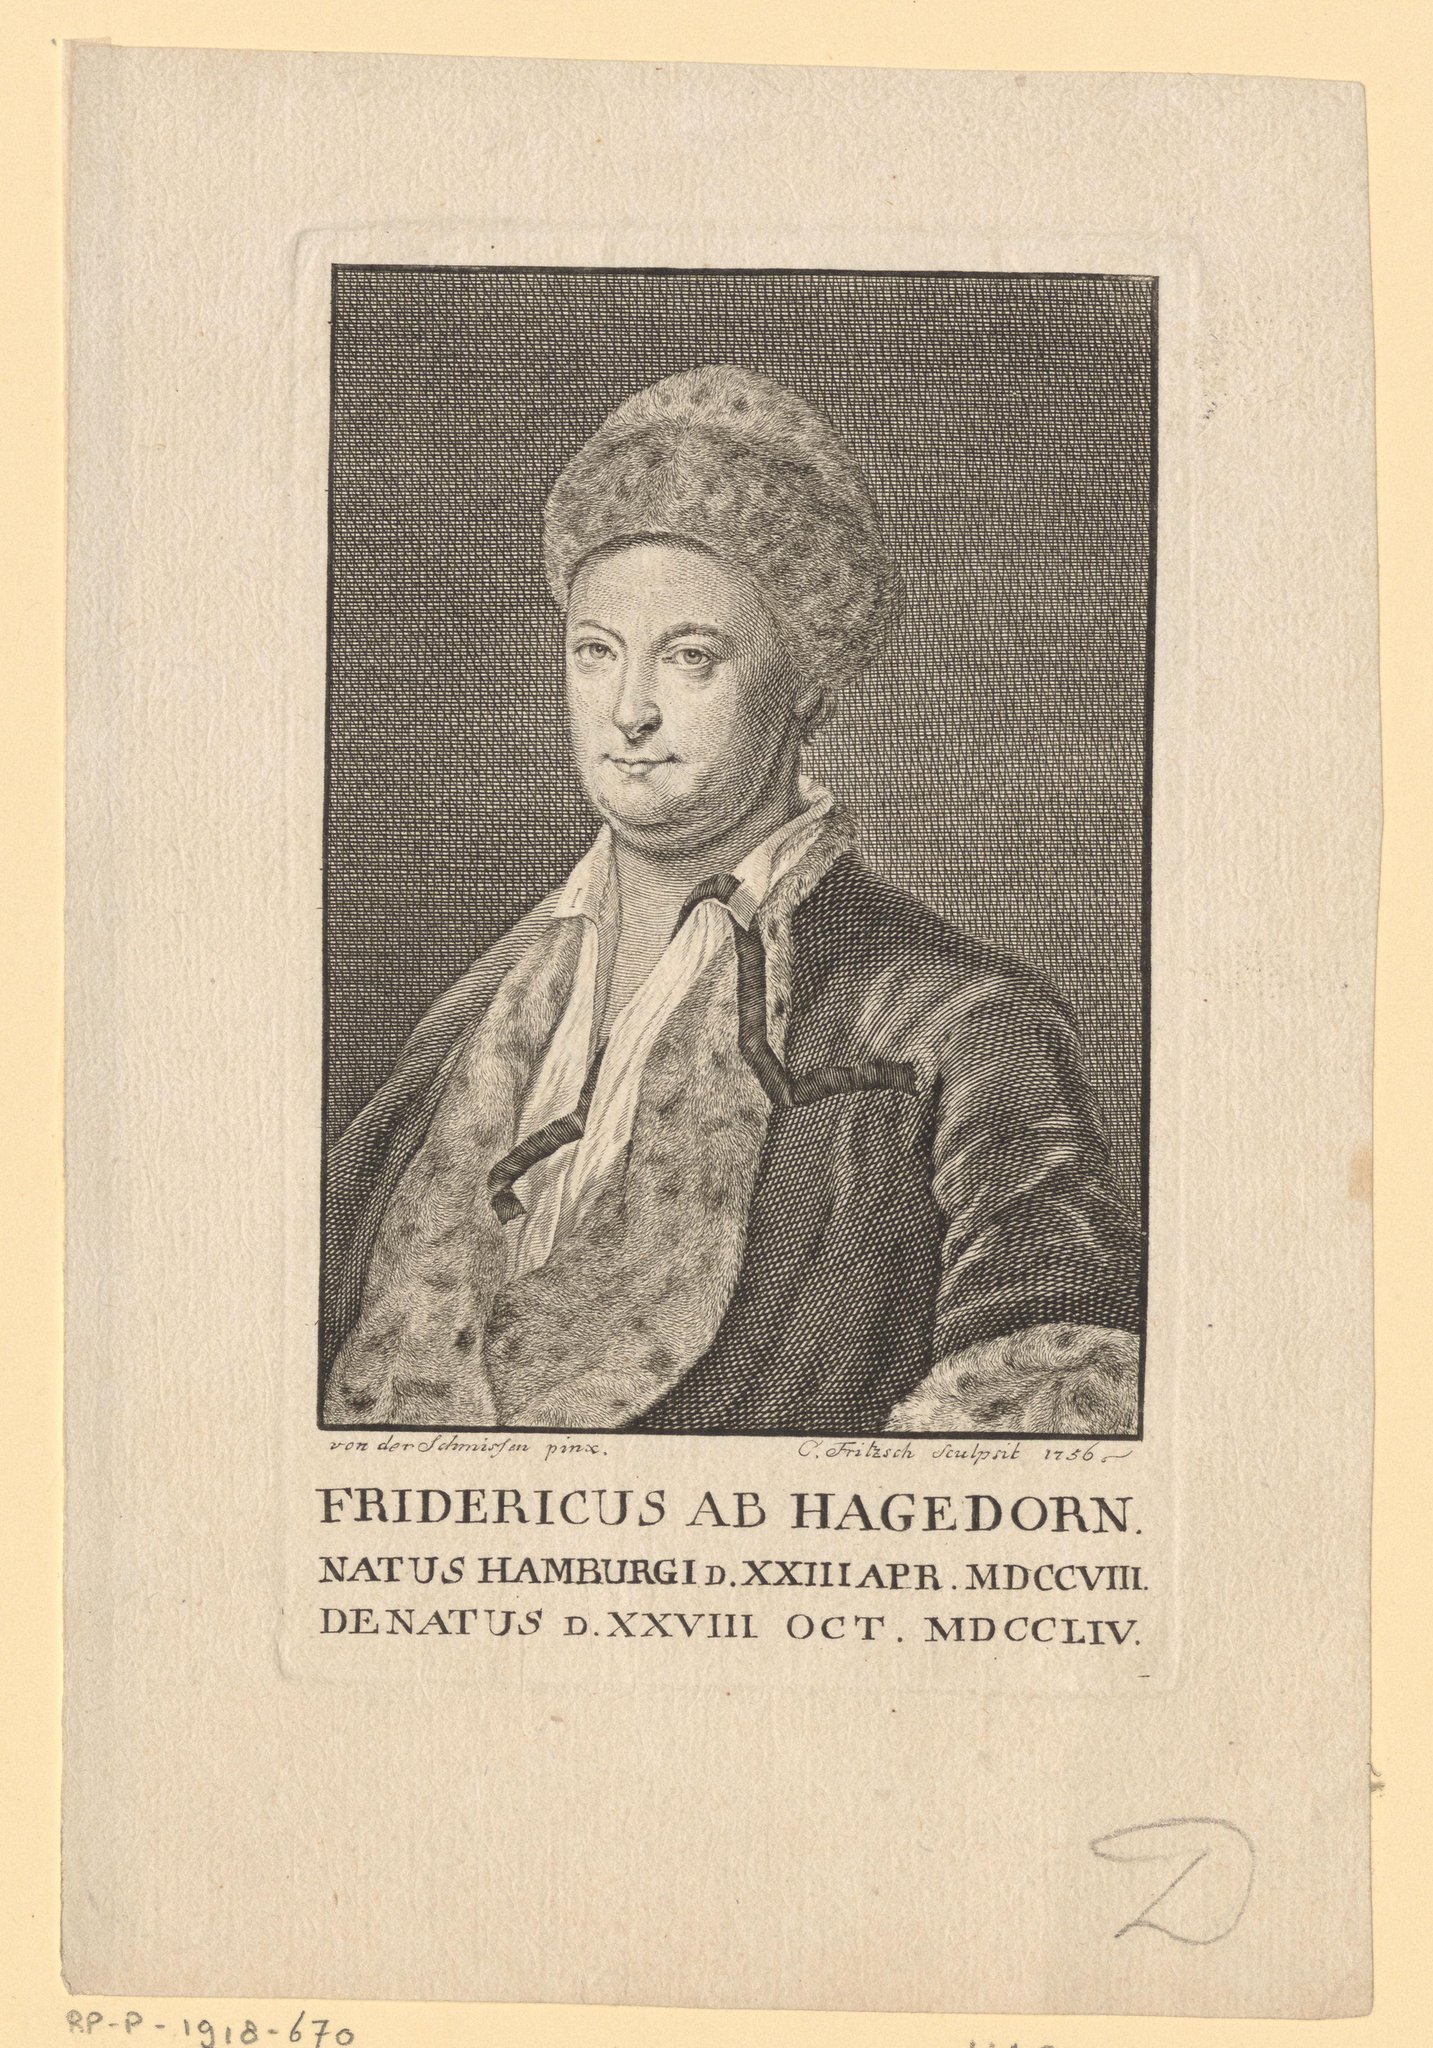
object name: print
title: Portret van Friedrich von Hagedorn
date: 1756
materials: paper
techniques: engraving, etching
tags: historical persons, writer, poet, author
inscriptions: collector's mark: Lugt 2228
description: Prent gebruikt in: Hagedorn, Friedrich von. Sämmtliche Poetische Werke. Hamburg: Johann Carl Bohn,1757. Prent ook gebruikt in de 1760-editie.